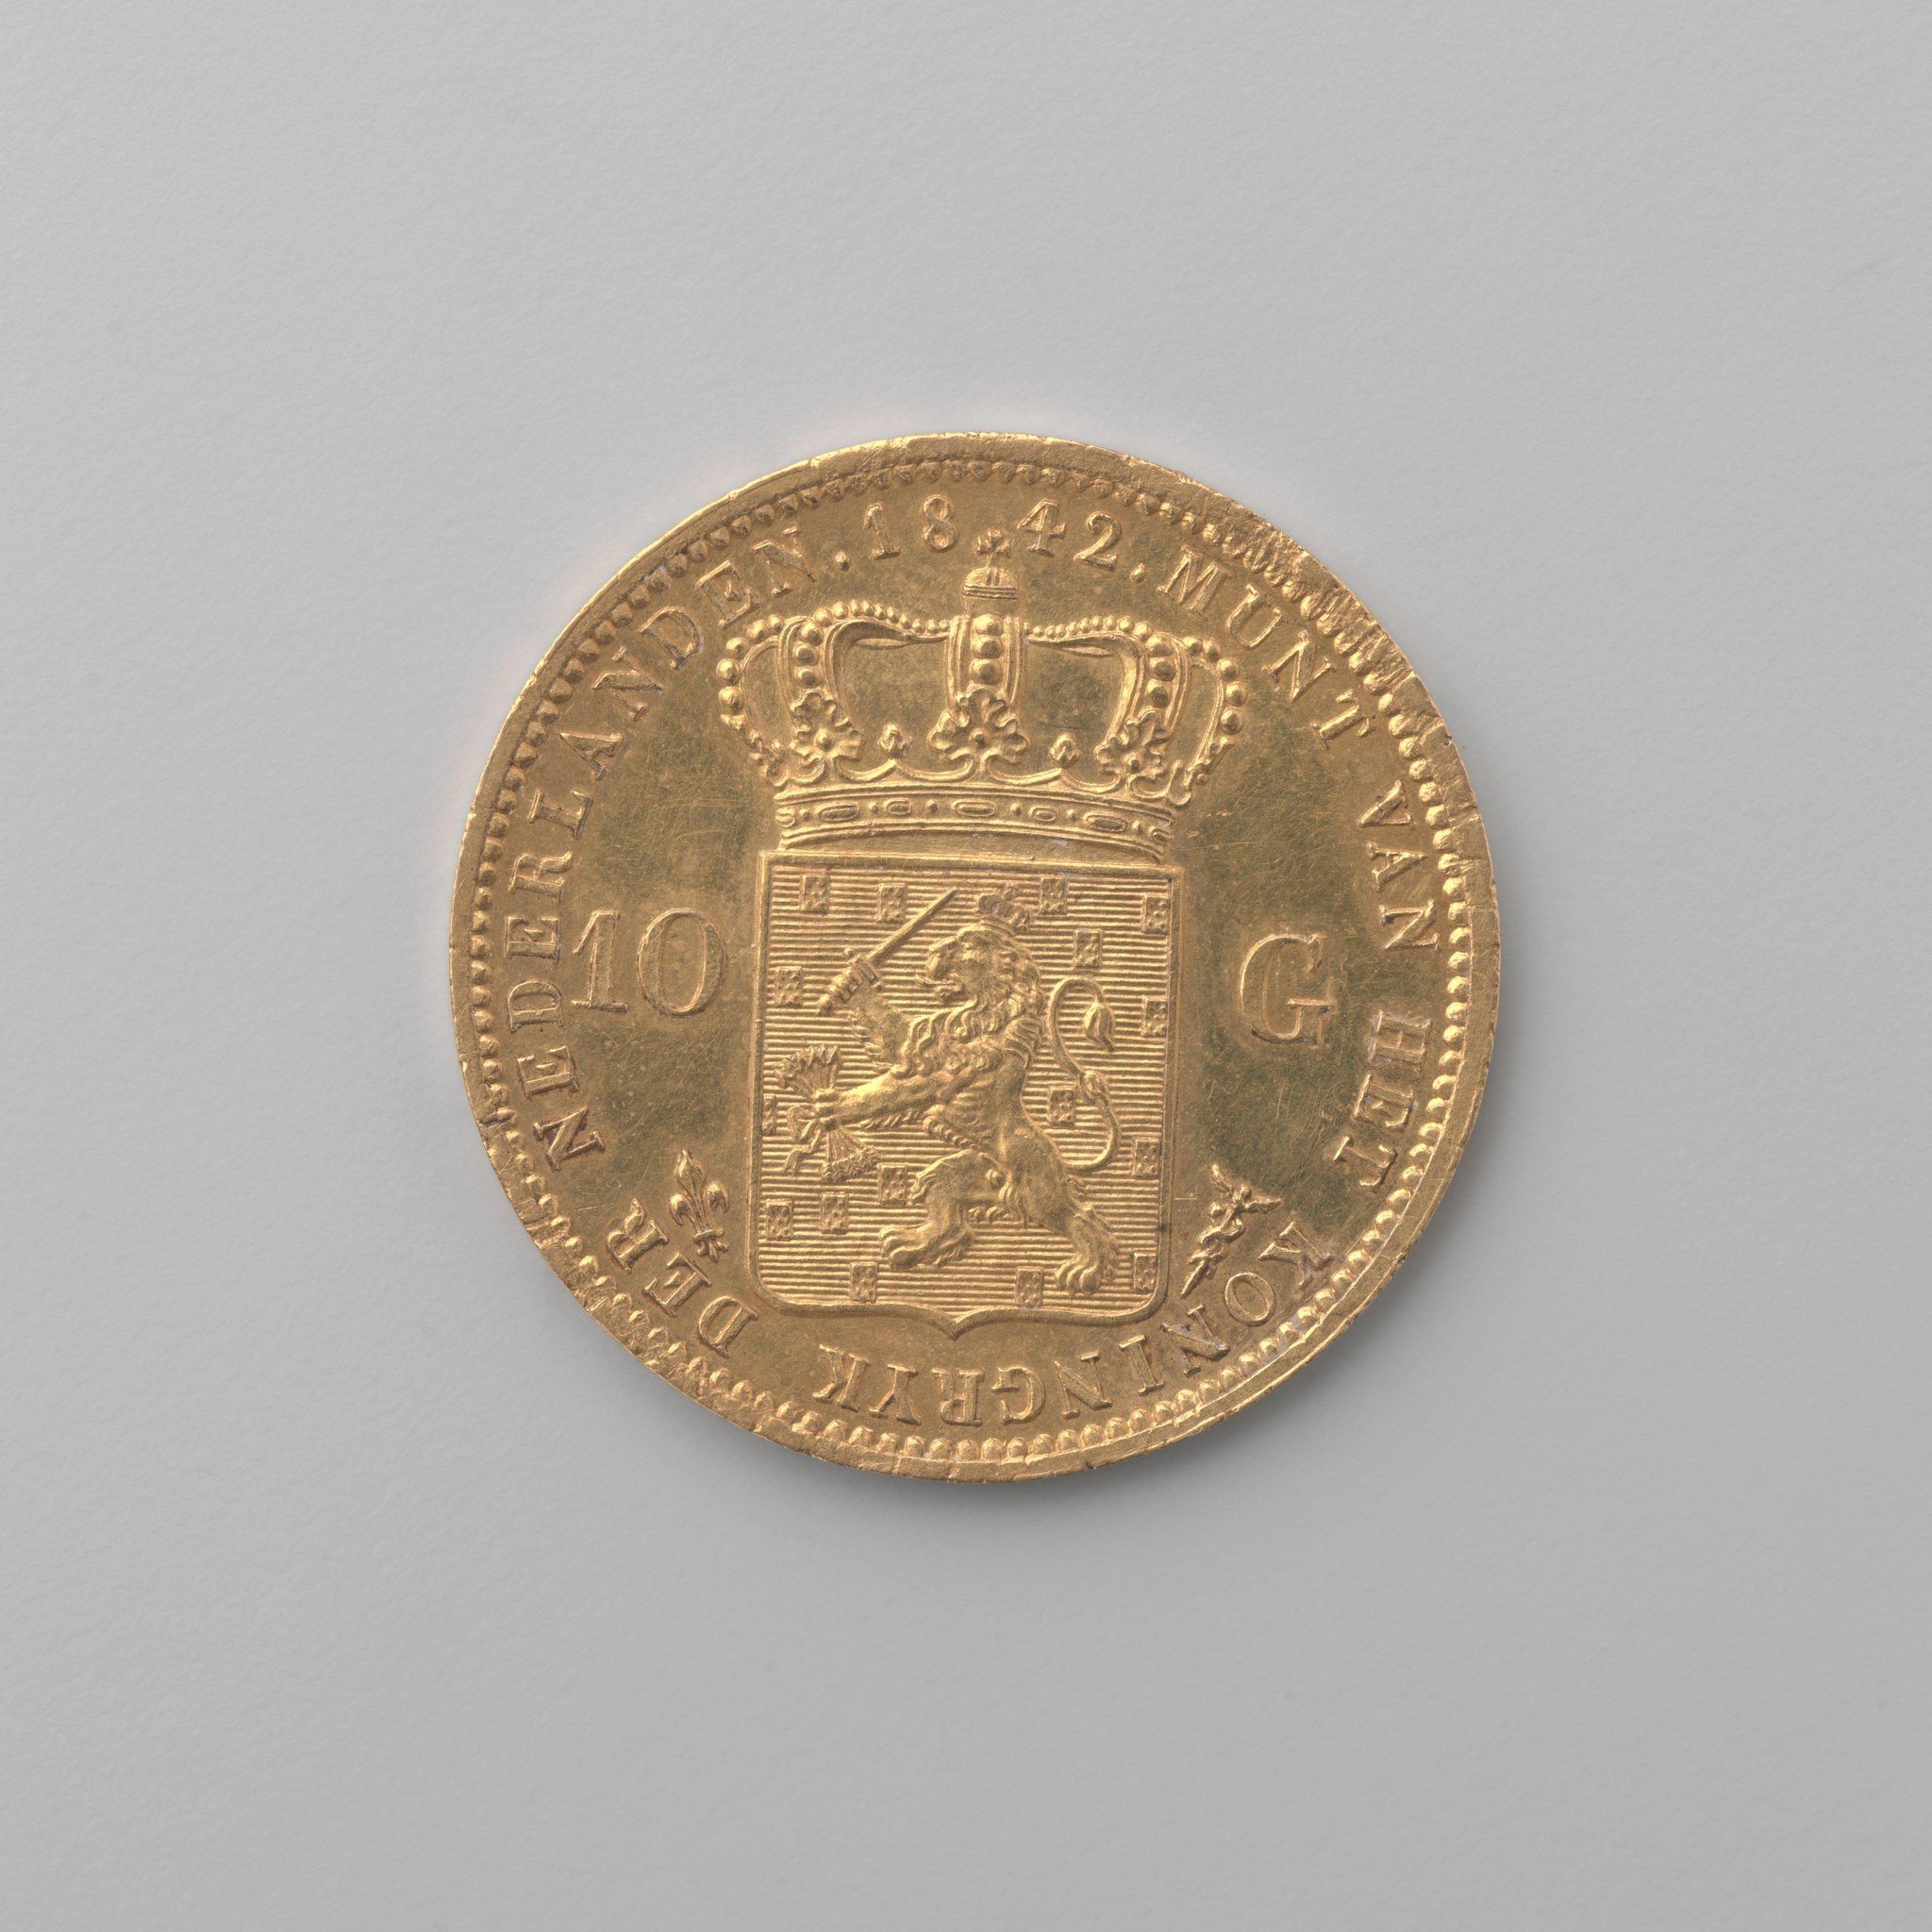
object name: coin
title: Nederland, 10 gulden, 1842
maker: william ii of the netherlands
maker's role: koning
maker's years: 1792-1849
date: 1842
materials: gold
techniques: striking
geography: utrecht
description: Gouden munt. Voorzijde: borstbeeld naar rechts. Keerzijde: tussen waarde-aanduiding 10 G gekroond rijkswapenschild. Jaartal boven kroon. Randschrift.